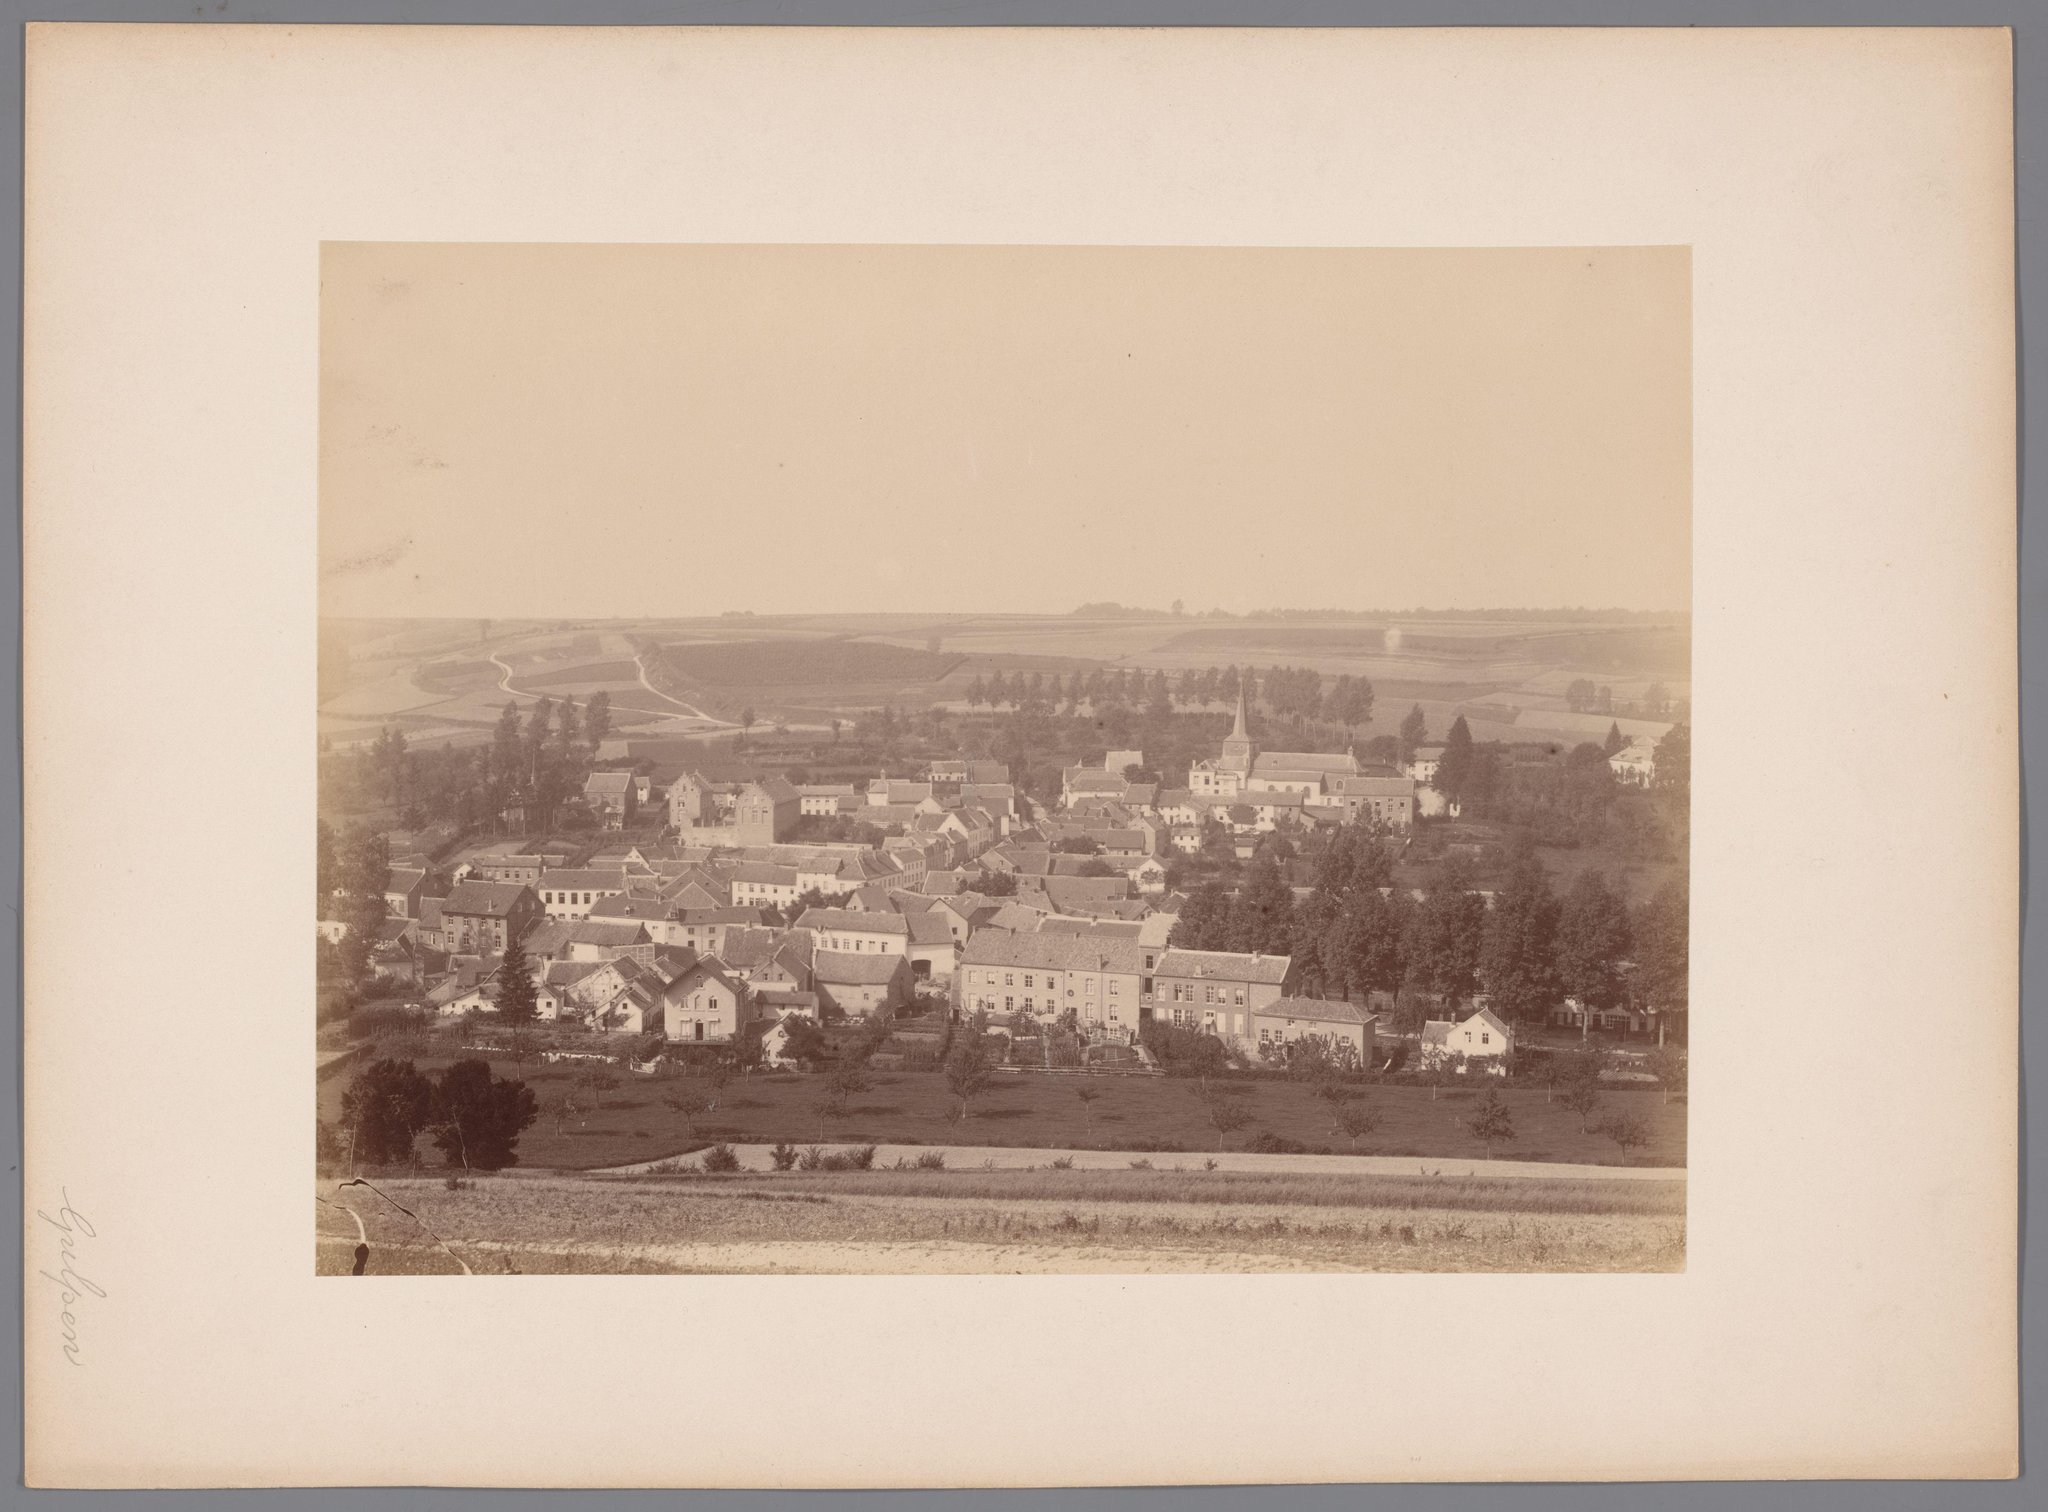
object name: photograph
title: Gezicht op Gulpen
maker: anoniem (monumentenzorg)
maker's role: fotograaf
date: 1890-1920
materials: cardboard, photographic support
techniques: albumen print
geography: gulpen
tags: city-view in general; 'veduta'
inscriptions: annotation: ‘Panorama of Gulpen’, annotation: ‘Gulpen’